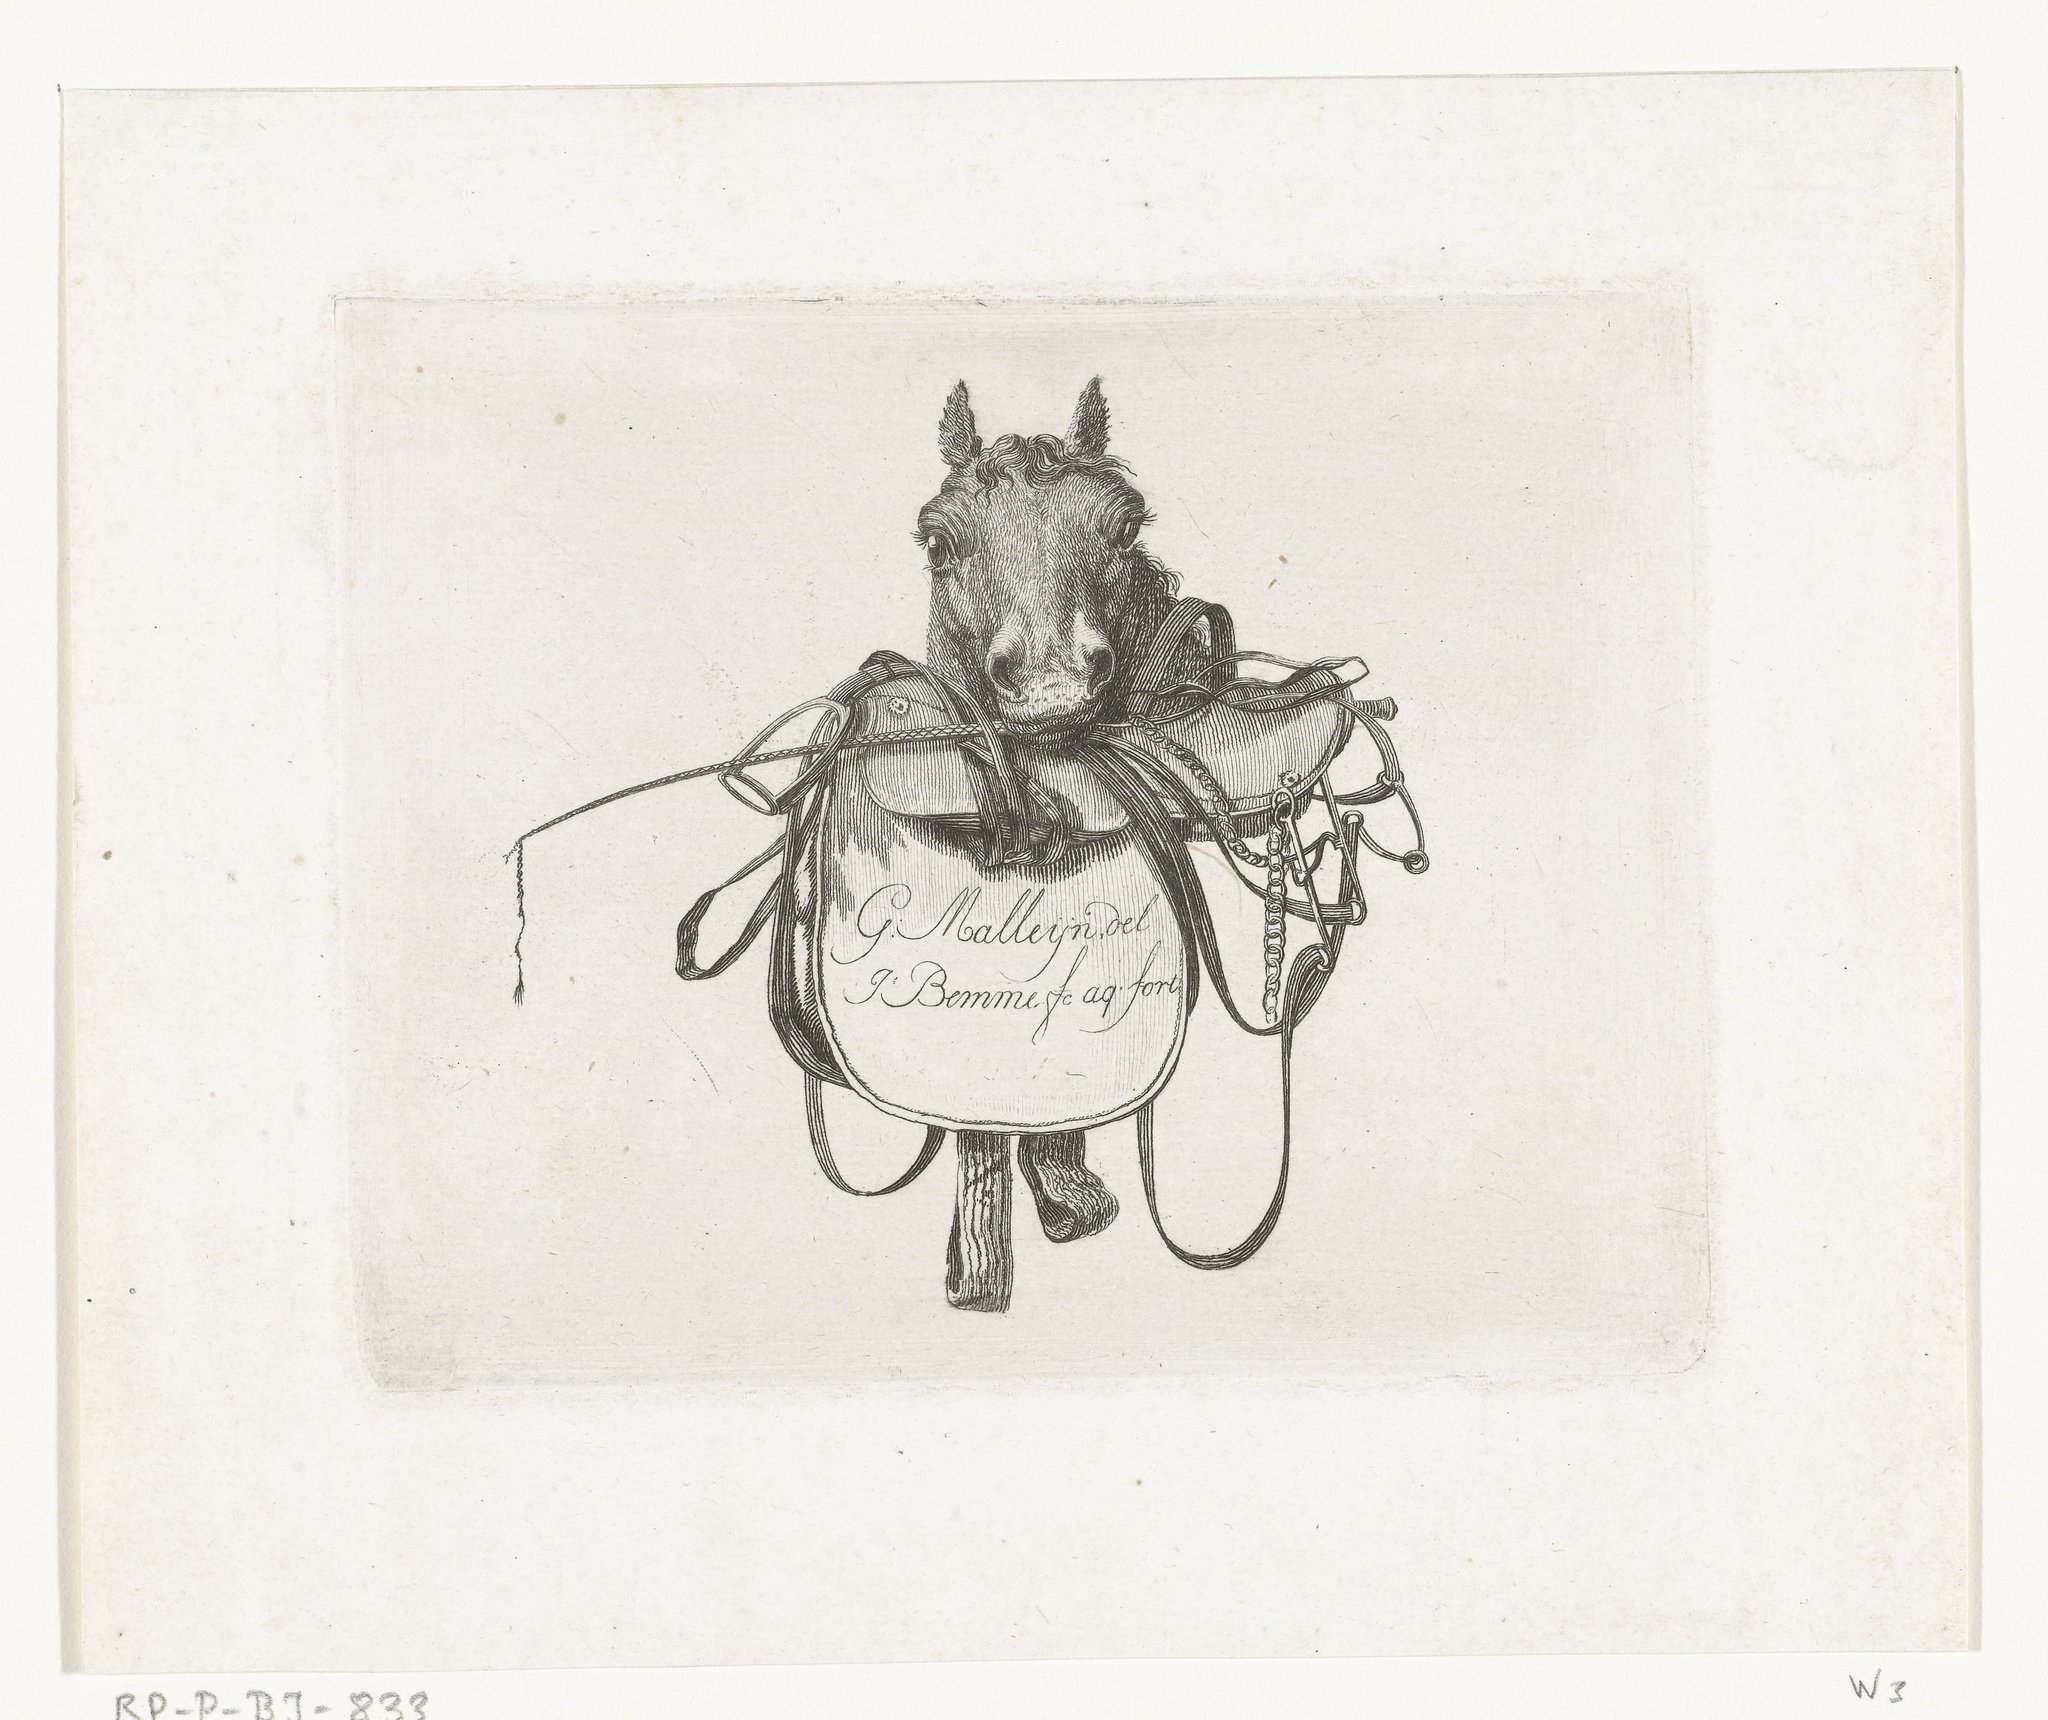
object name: titelprent, frontispice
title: Paardenhoofden naar Gerrit Malleyn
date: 1801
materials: paper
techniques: etching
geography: rotterdam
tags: horse (+ head of an animal)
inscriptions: collector's mark: Lugt 2165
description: Titelblad van serie paardenkoppen. Paardenhoofd met zadel, teugels en zweep in de bek.